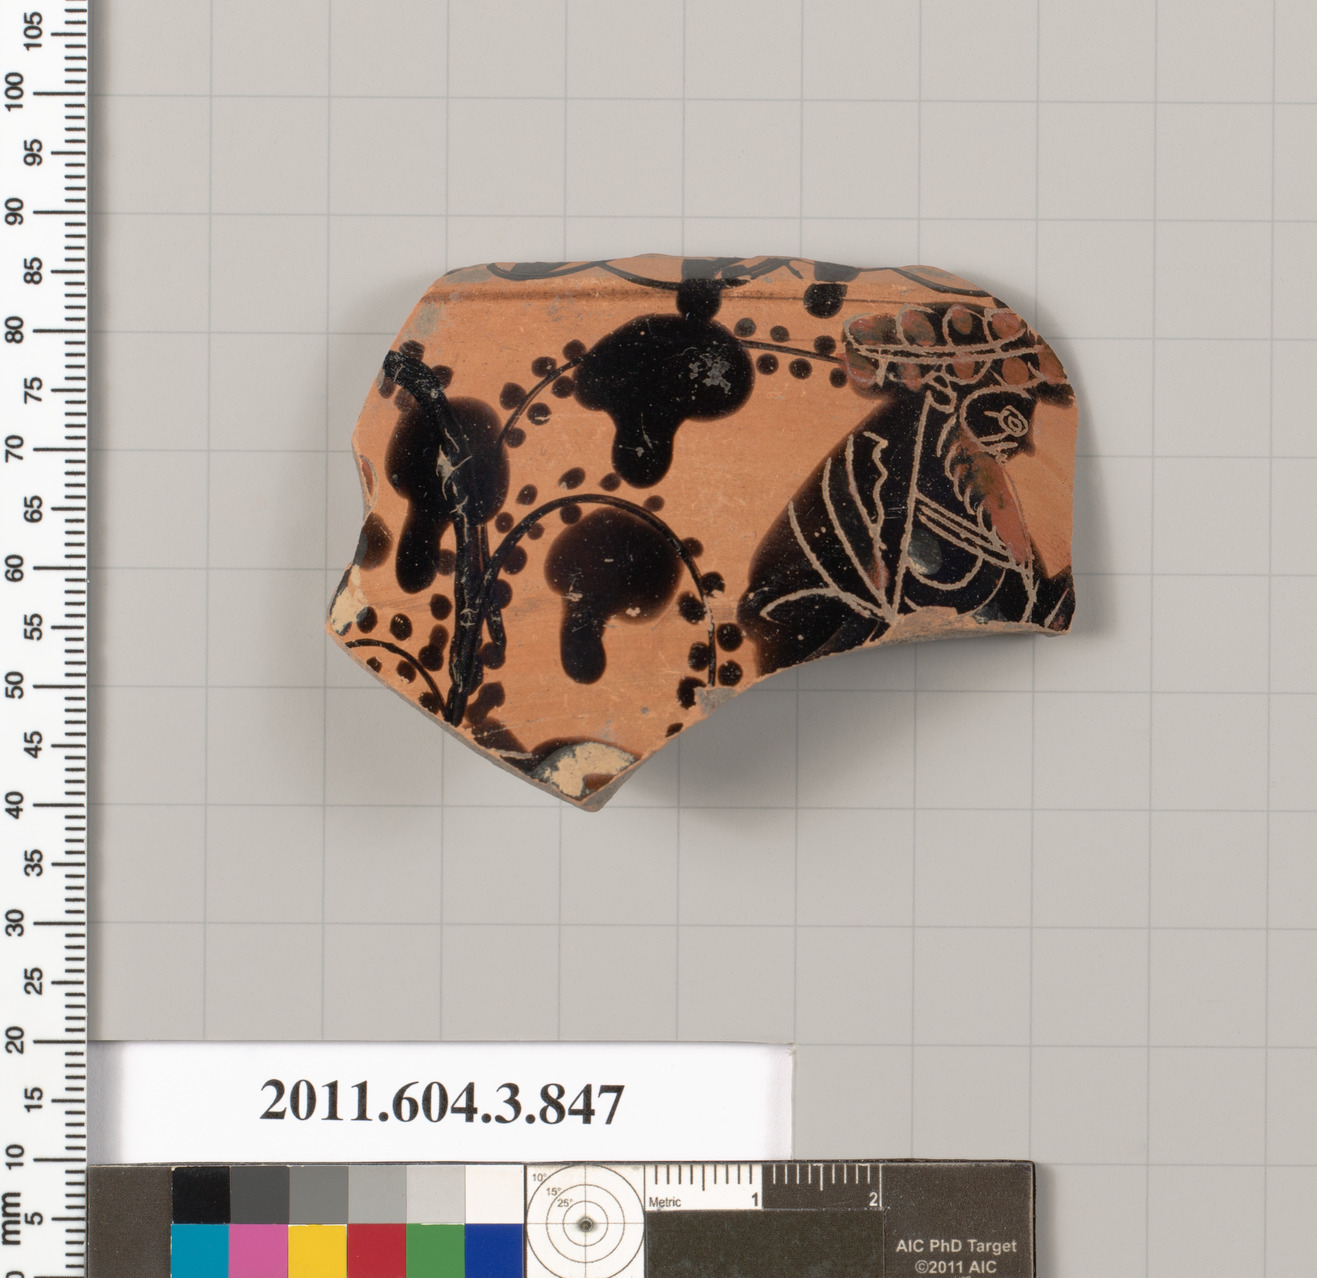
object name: lekythos fragment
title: Terracotta fragment of a lekythos (oil flask)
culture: greek, attic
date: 534-468 BCE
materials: terracotta